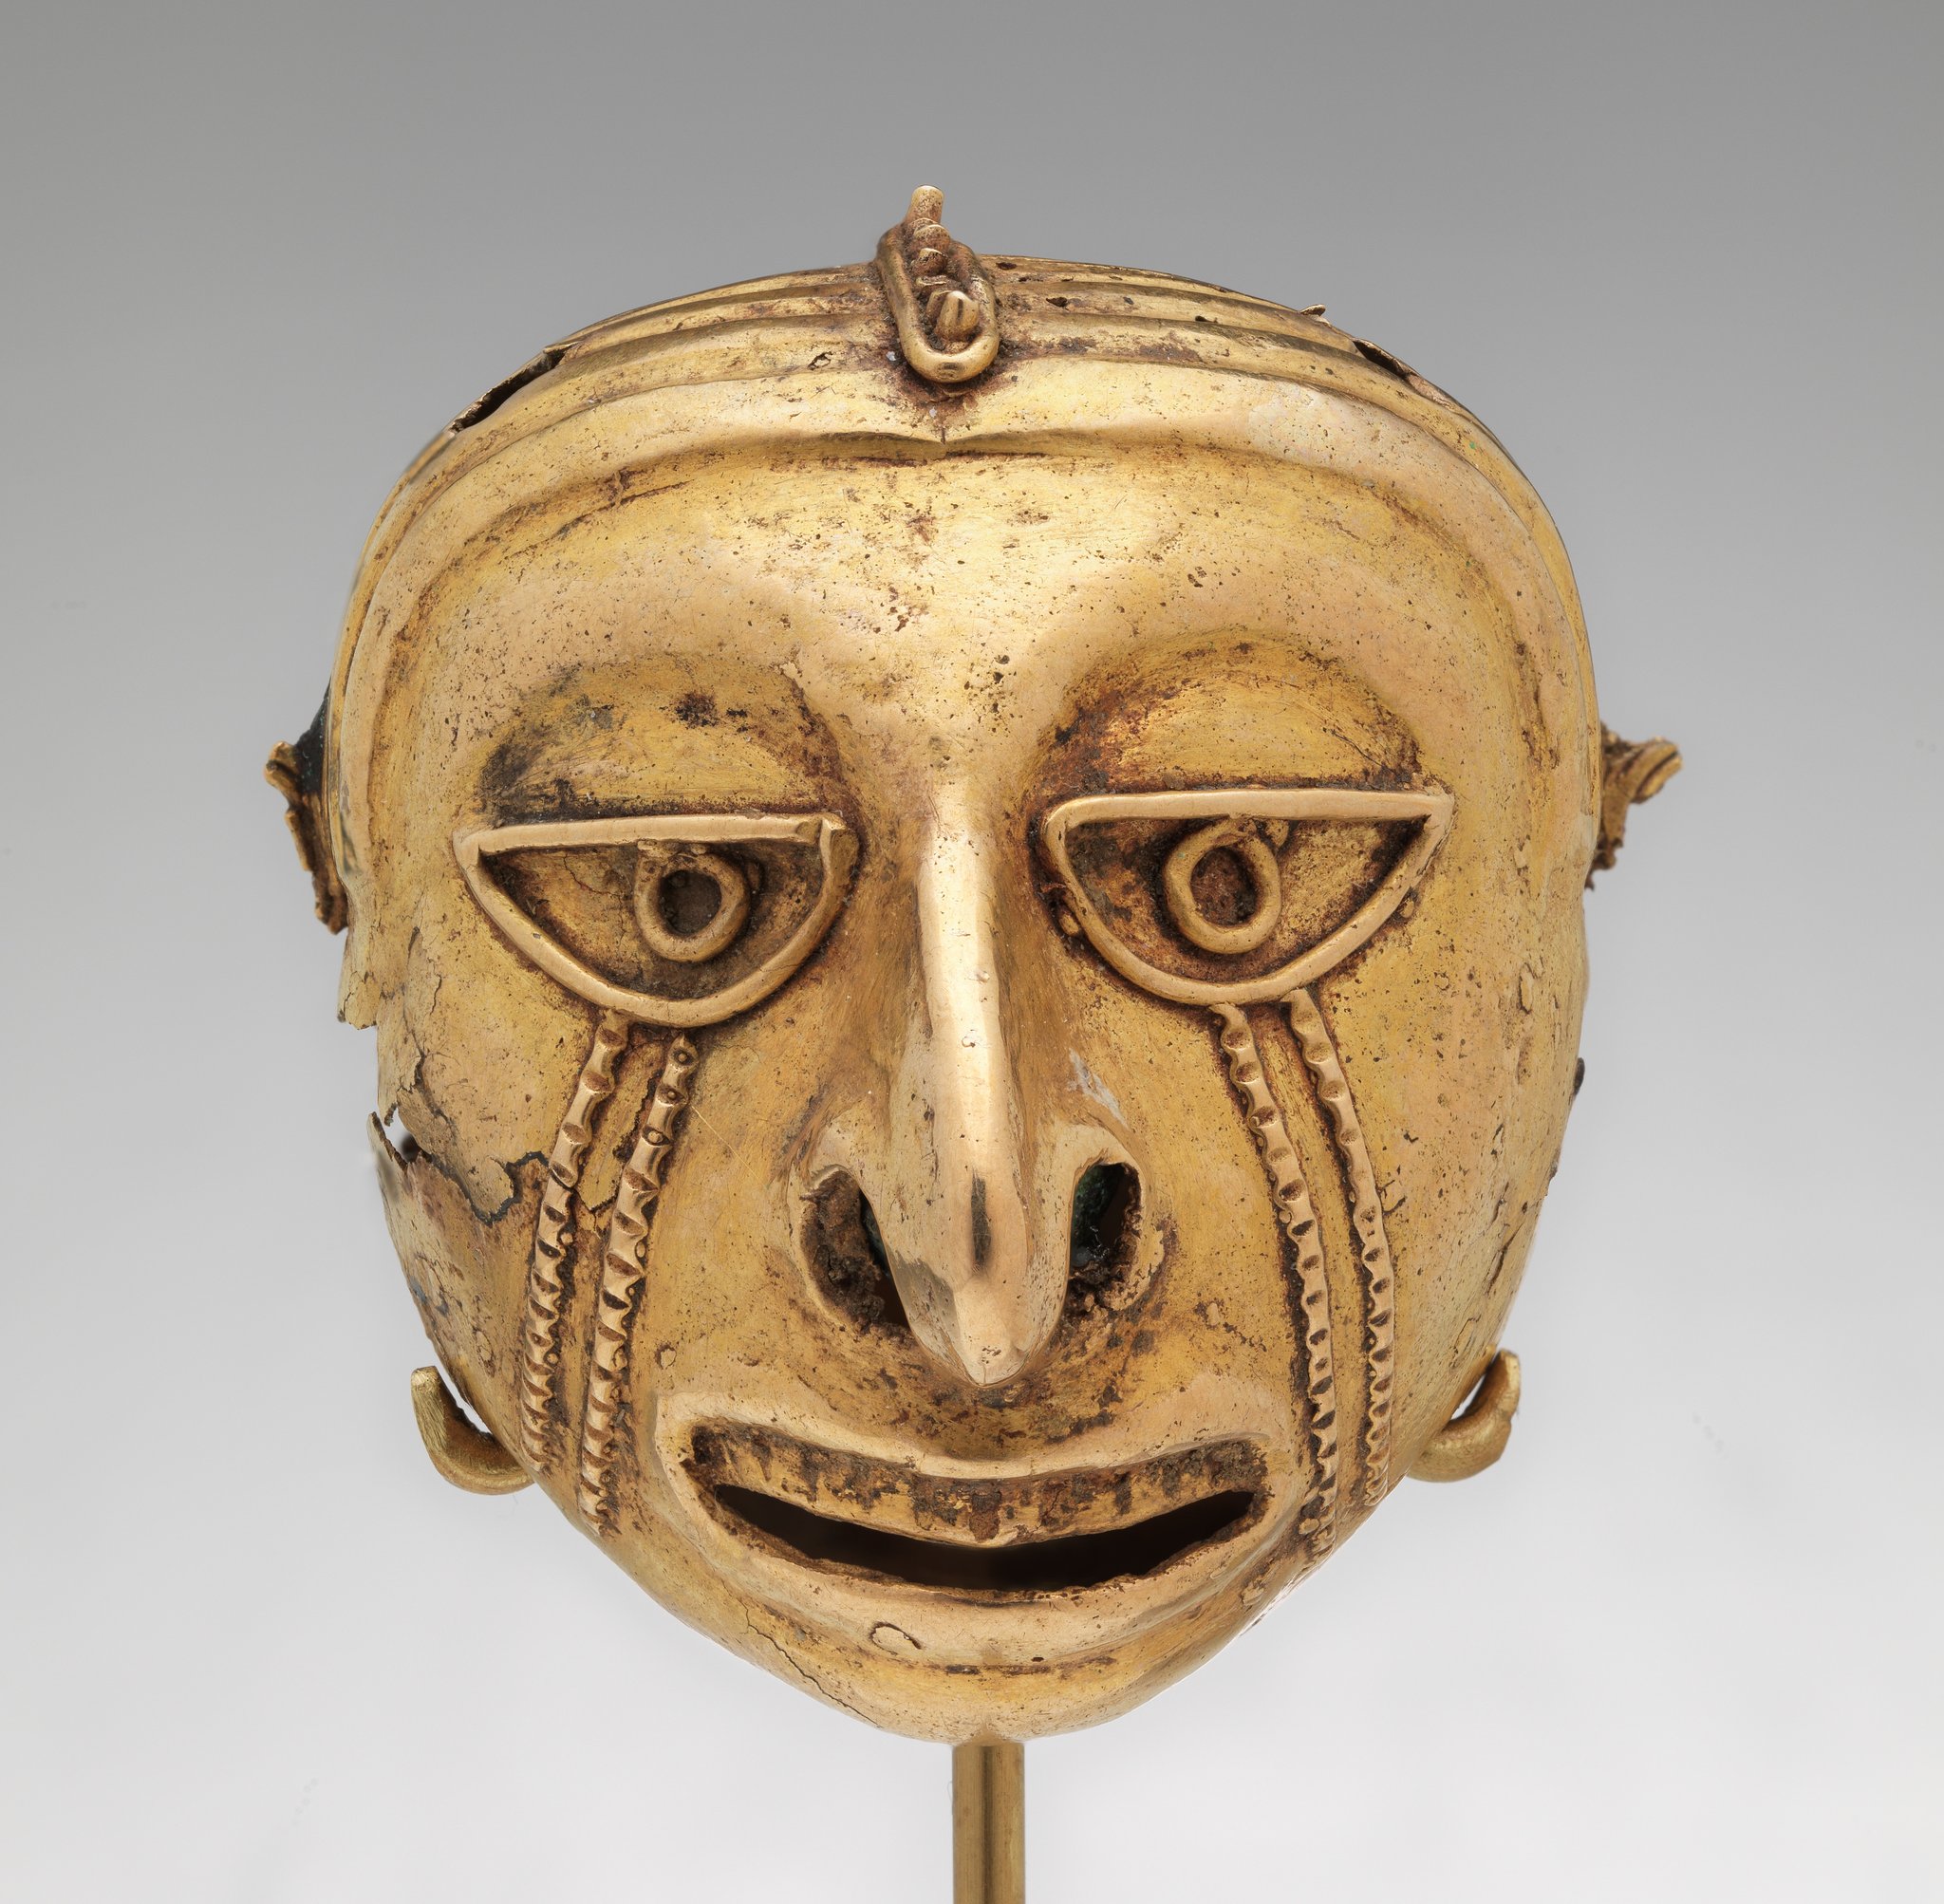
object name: bell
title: Head-shaped bell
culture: mexica, aztec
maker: mexica or mixtec (ñuu savi) artists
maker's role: artist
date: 1325-1521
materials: gold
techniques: casting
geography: mexico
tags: heads